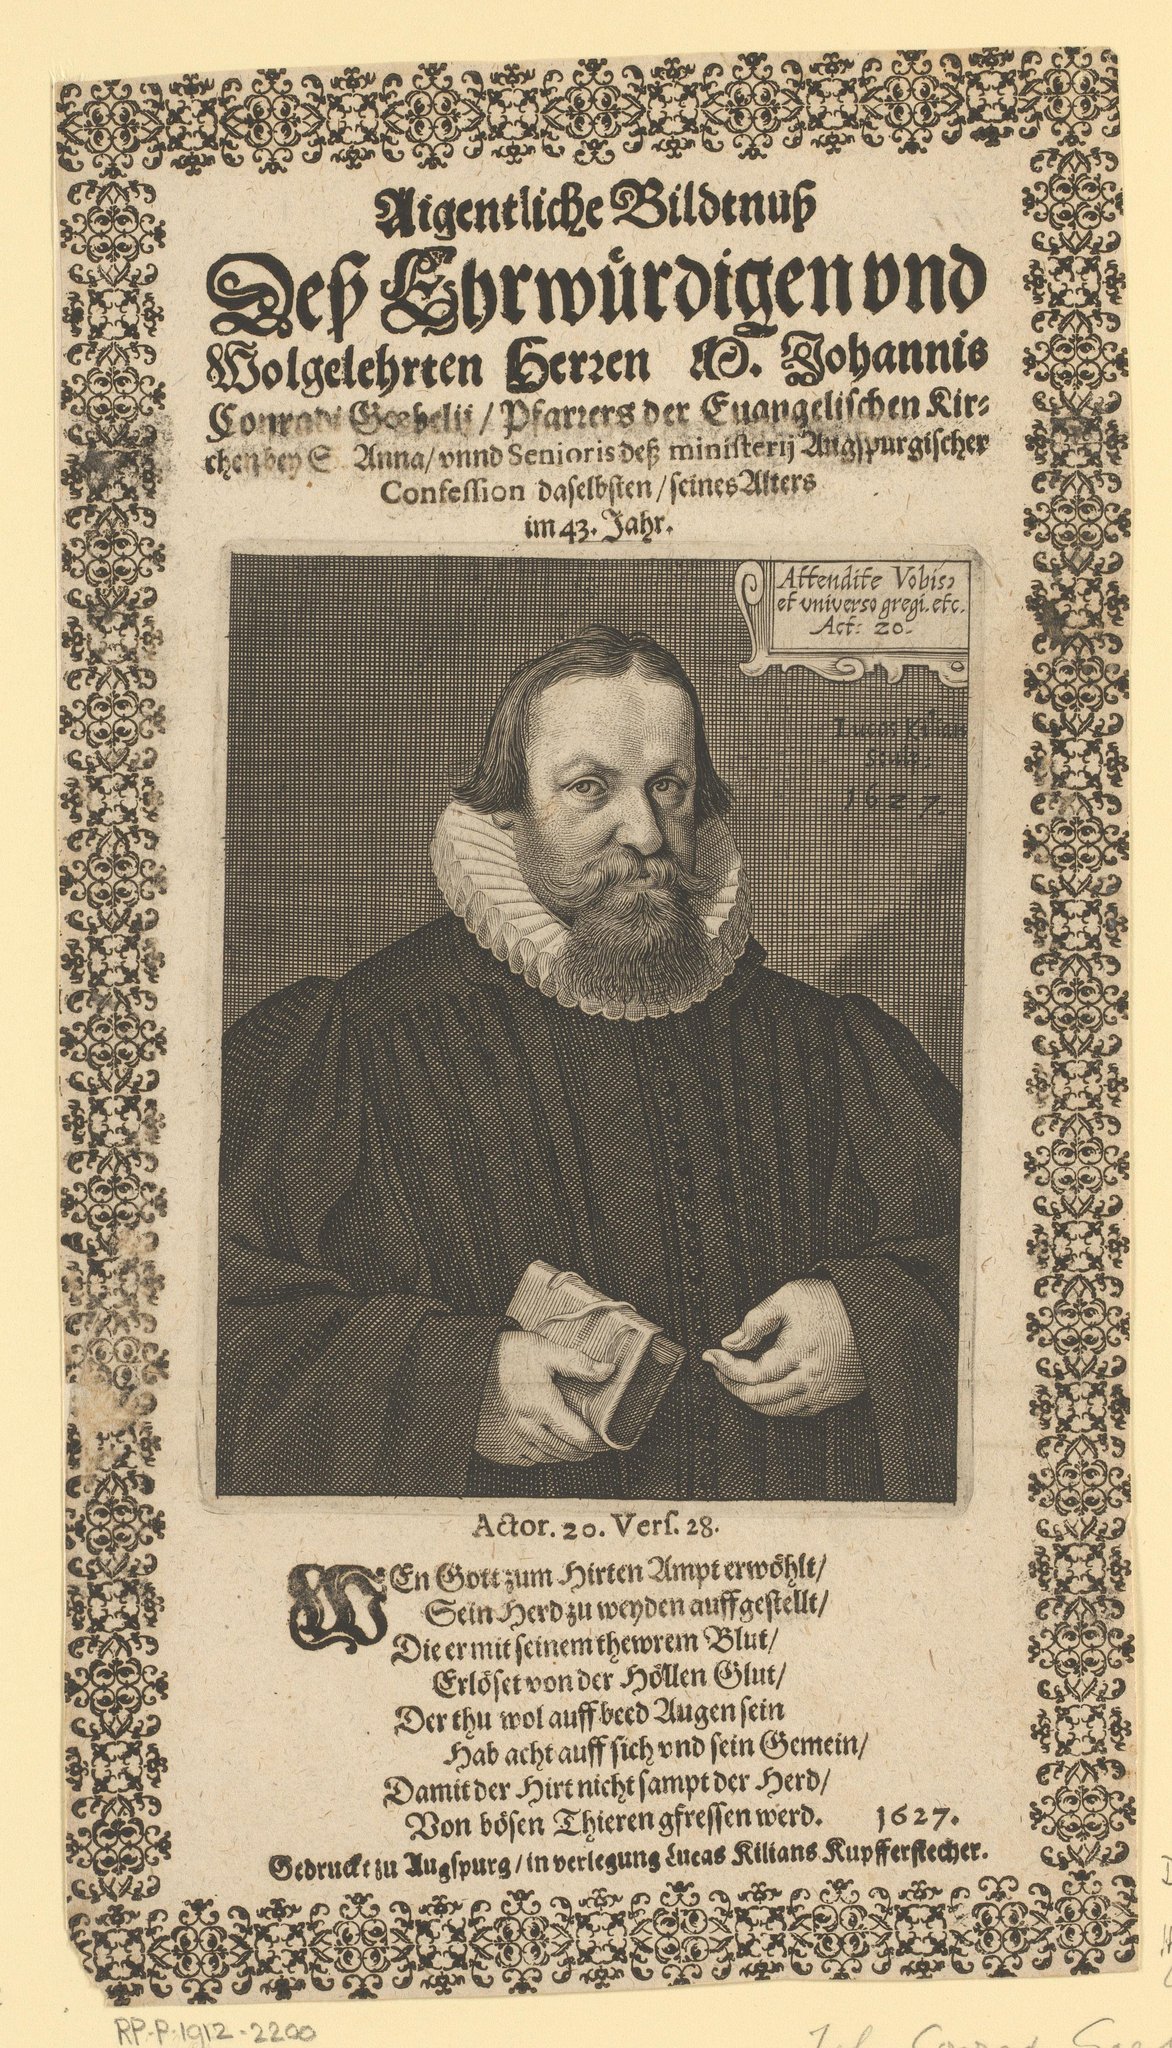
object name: print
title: Portretten van eerbiedwaardige en geleerde mannen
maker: lucas kilian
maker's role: draughtsman, print maker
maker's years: 1579-1637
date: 1627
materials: paper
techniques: engraving, letterpress printing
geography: augsburg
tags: augsburg, historical persons, book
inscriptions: collector's mark: Lugt 2228